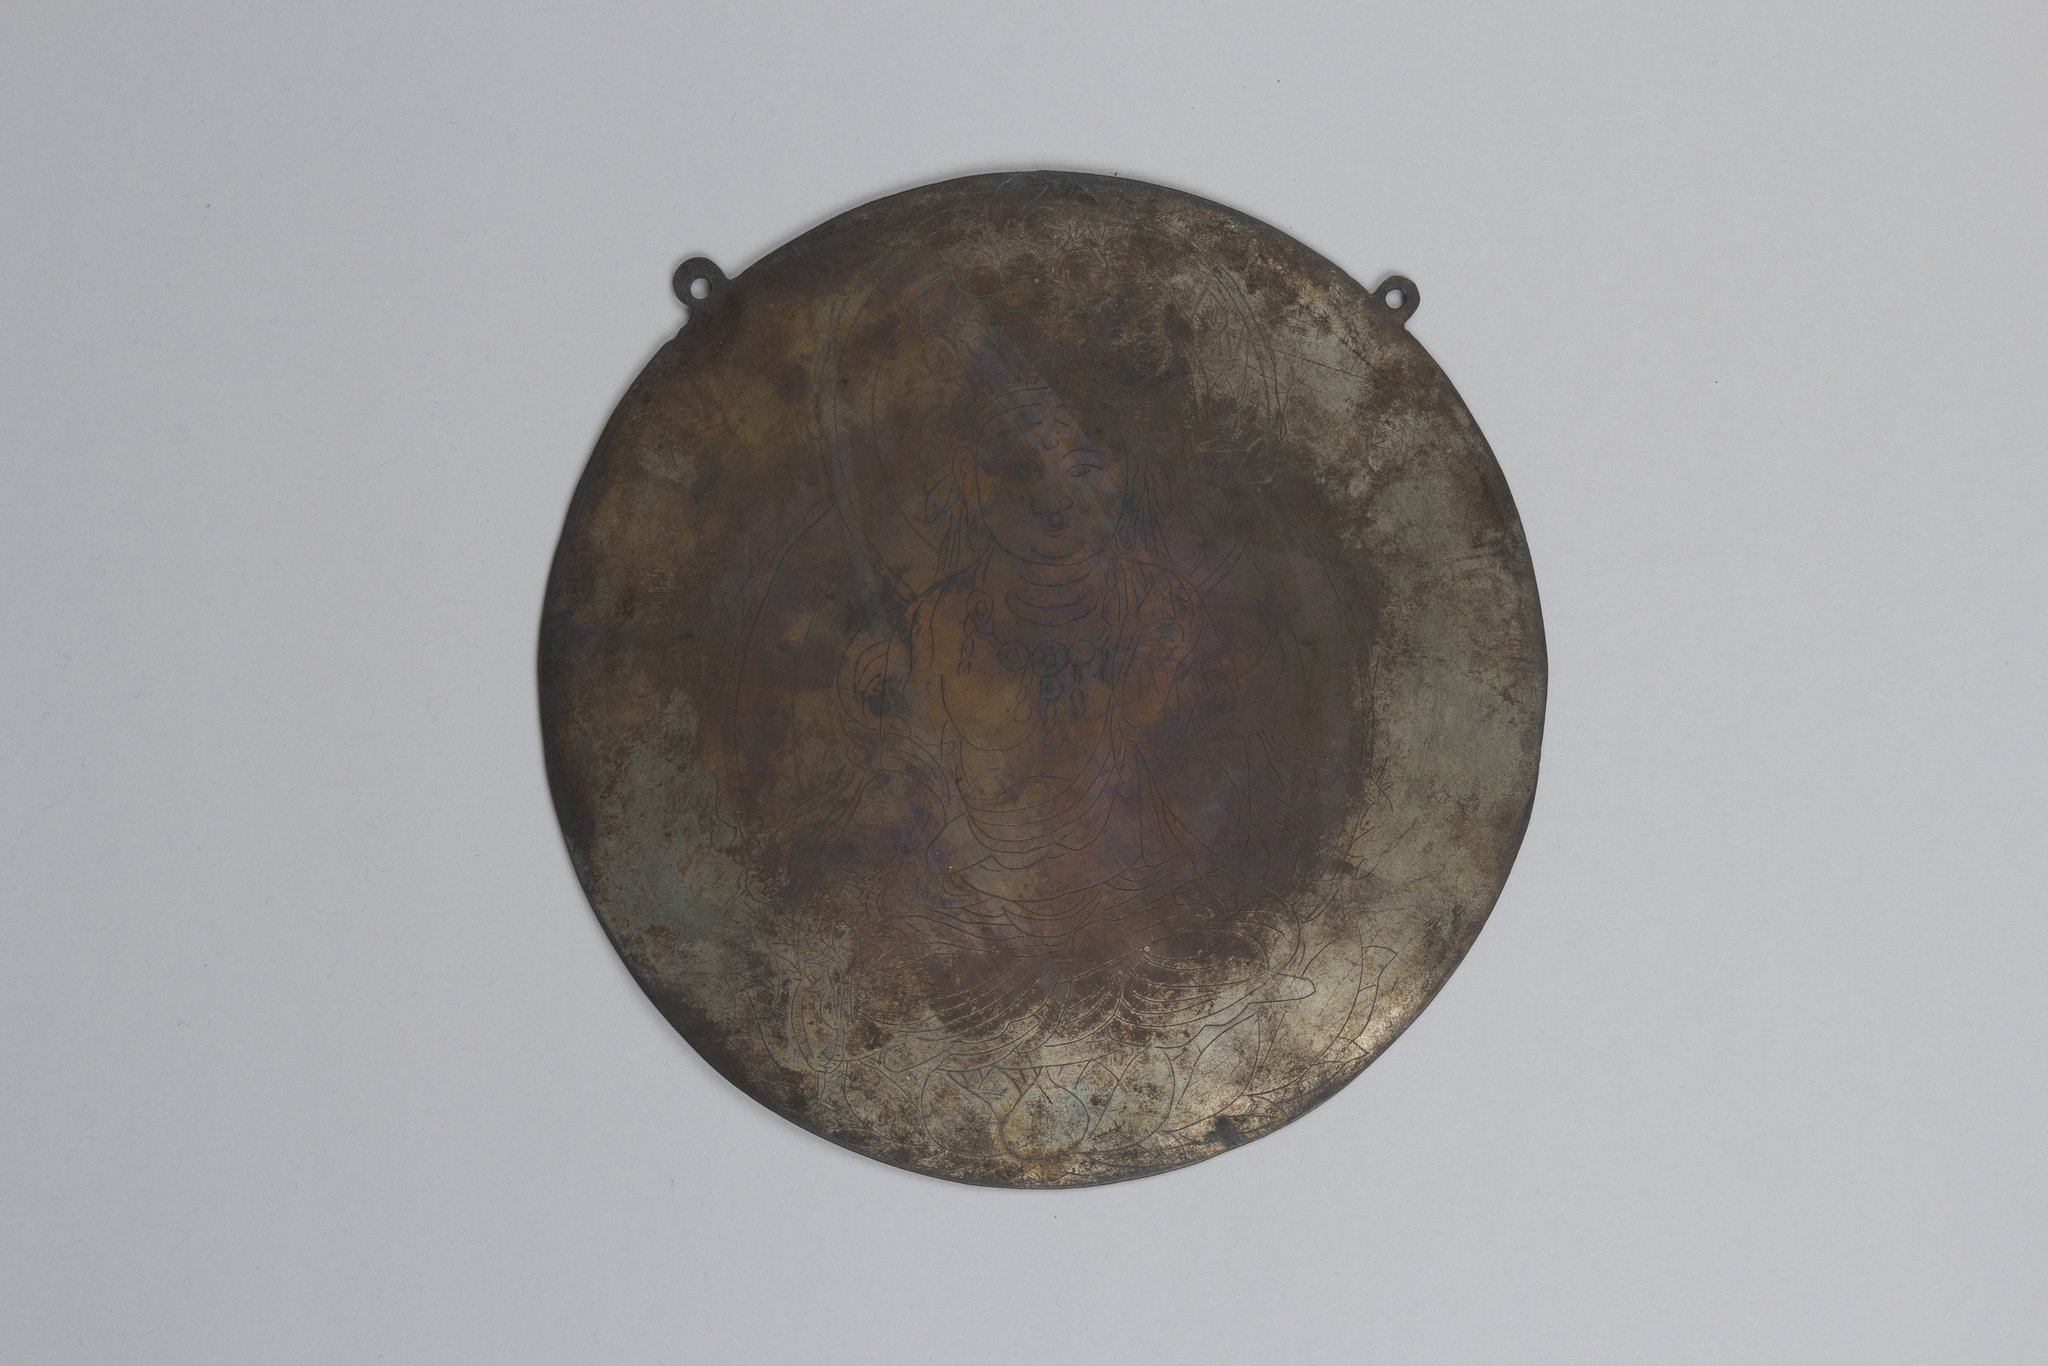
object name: votive mirror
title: Votive Mirror with Eleven-Headed Kannon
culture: japanese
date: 1101-1200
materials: gilt bronze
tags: bodhisattvas